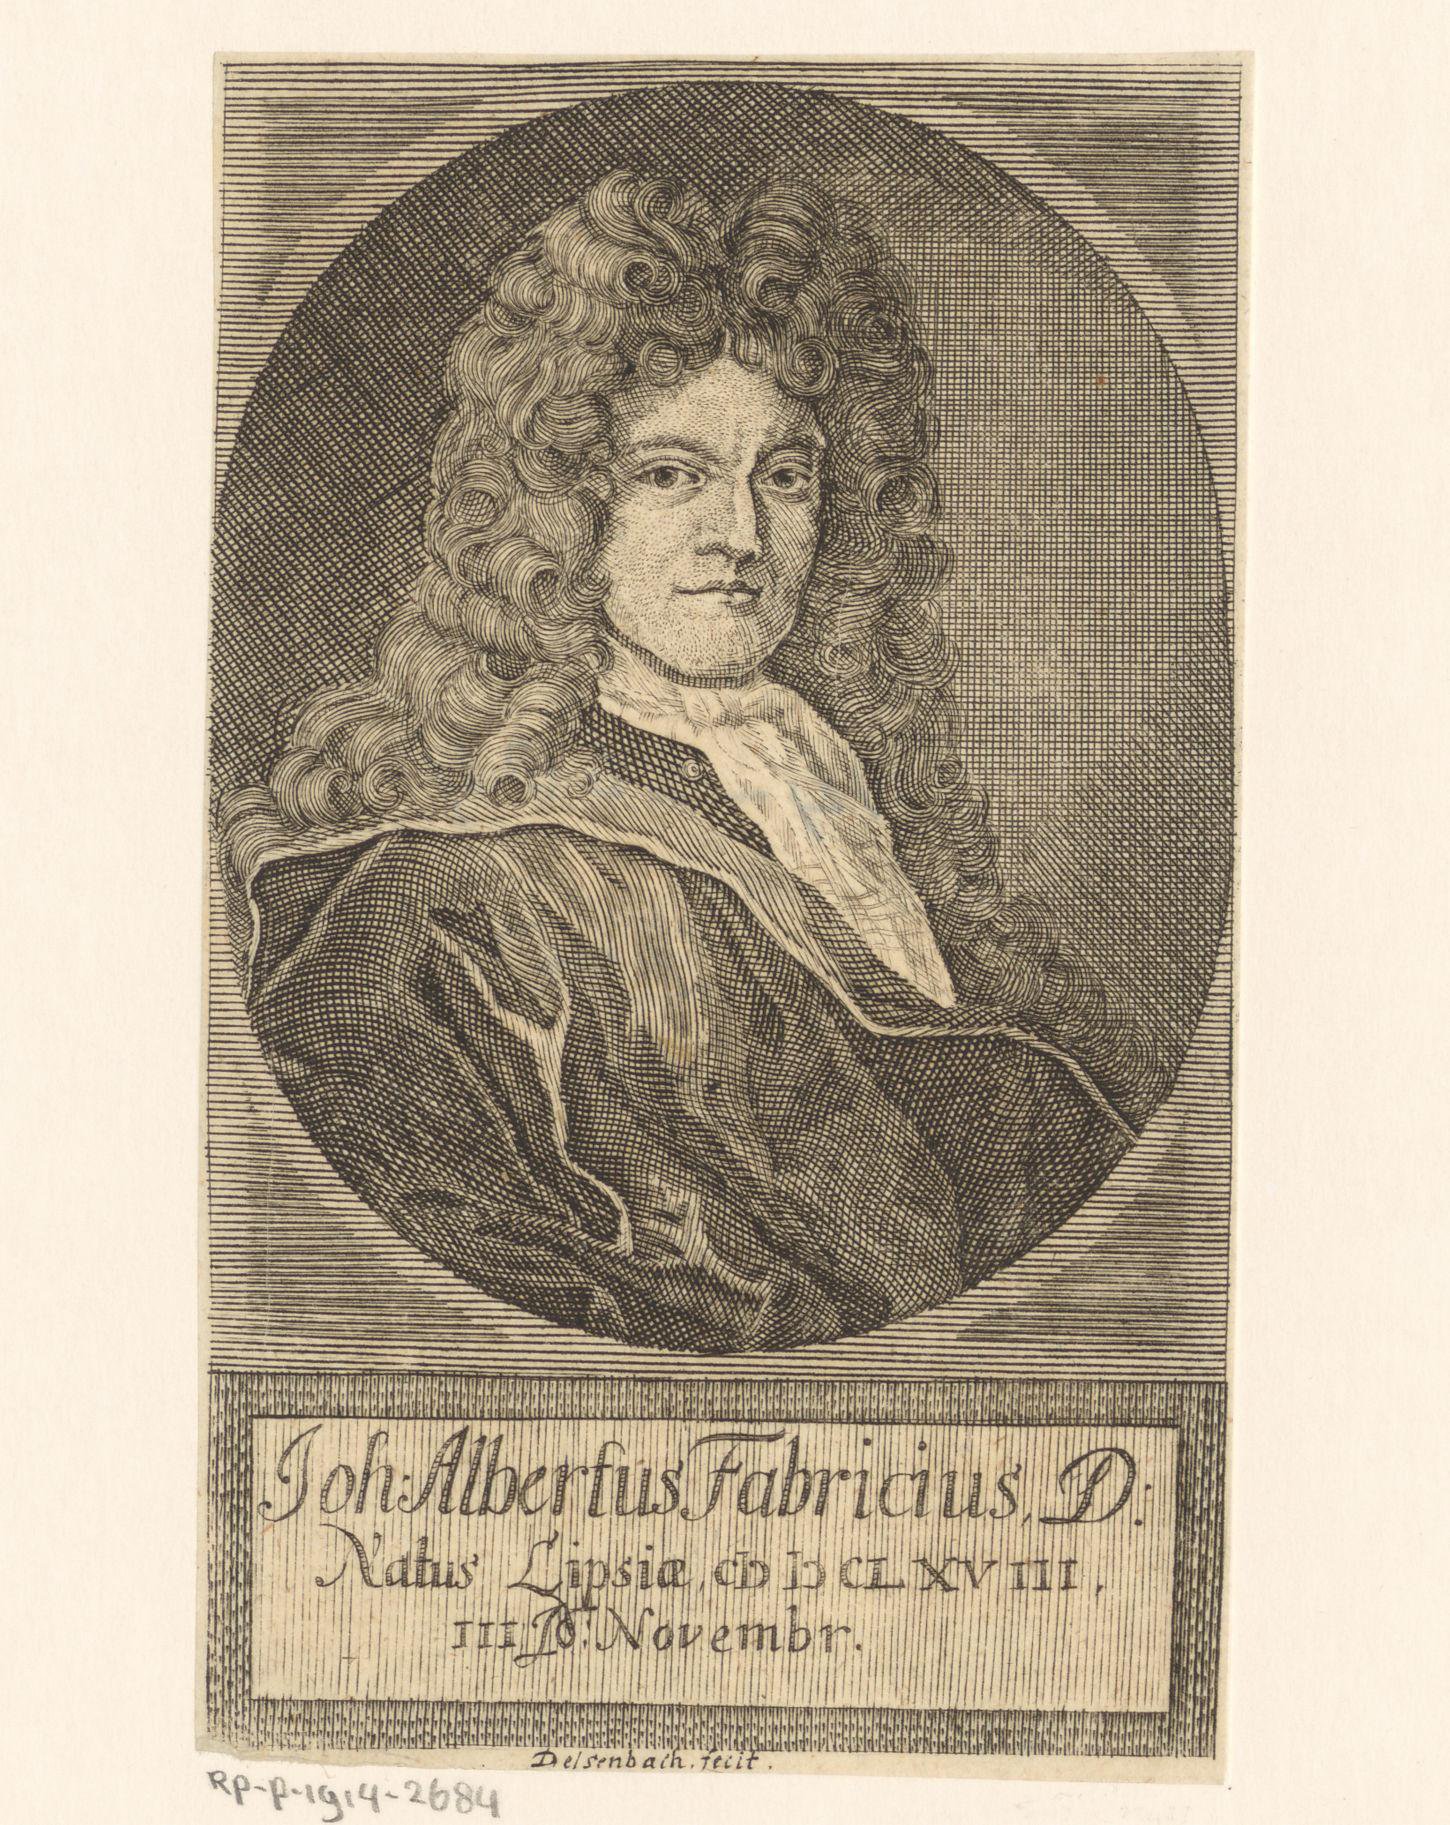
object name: print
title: Portret van Johann Albert Fabricius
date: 1710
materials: paper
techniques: engraving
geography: nuremberg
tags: johann albert fabricius, historical persons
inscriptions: collector's mark: Lugt 2228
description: Prent uit: Neue Bibliothec, oder Nachricht und Urtheile von neuen Büchern (...). 11 dln. Frankfurt en Leipzig: Rengerische Buchhandlung, 1710, dl. 3.